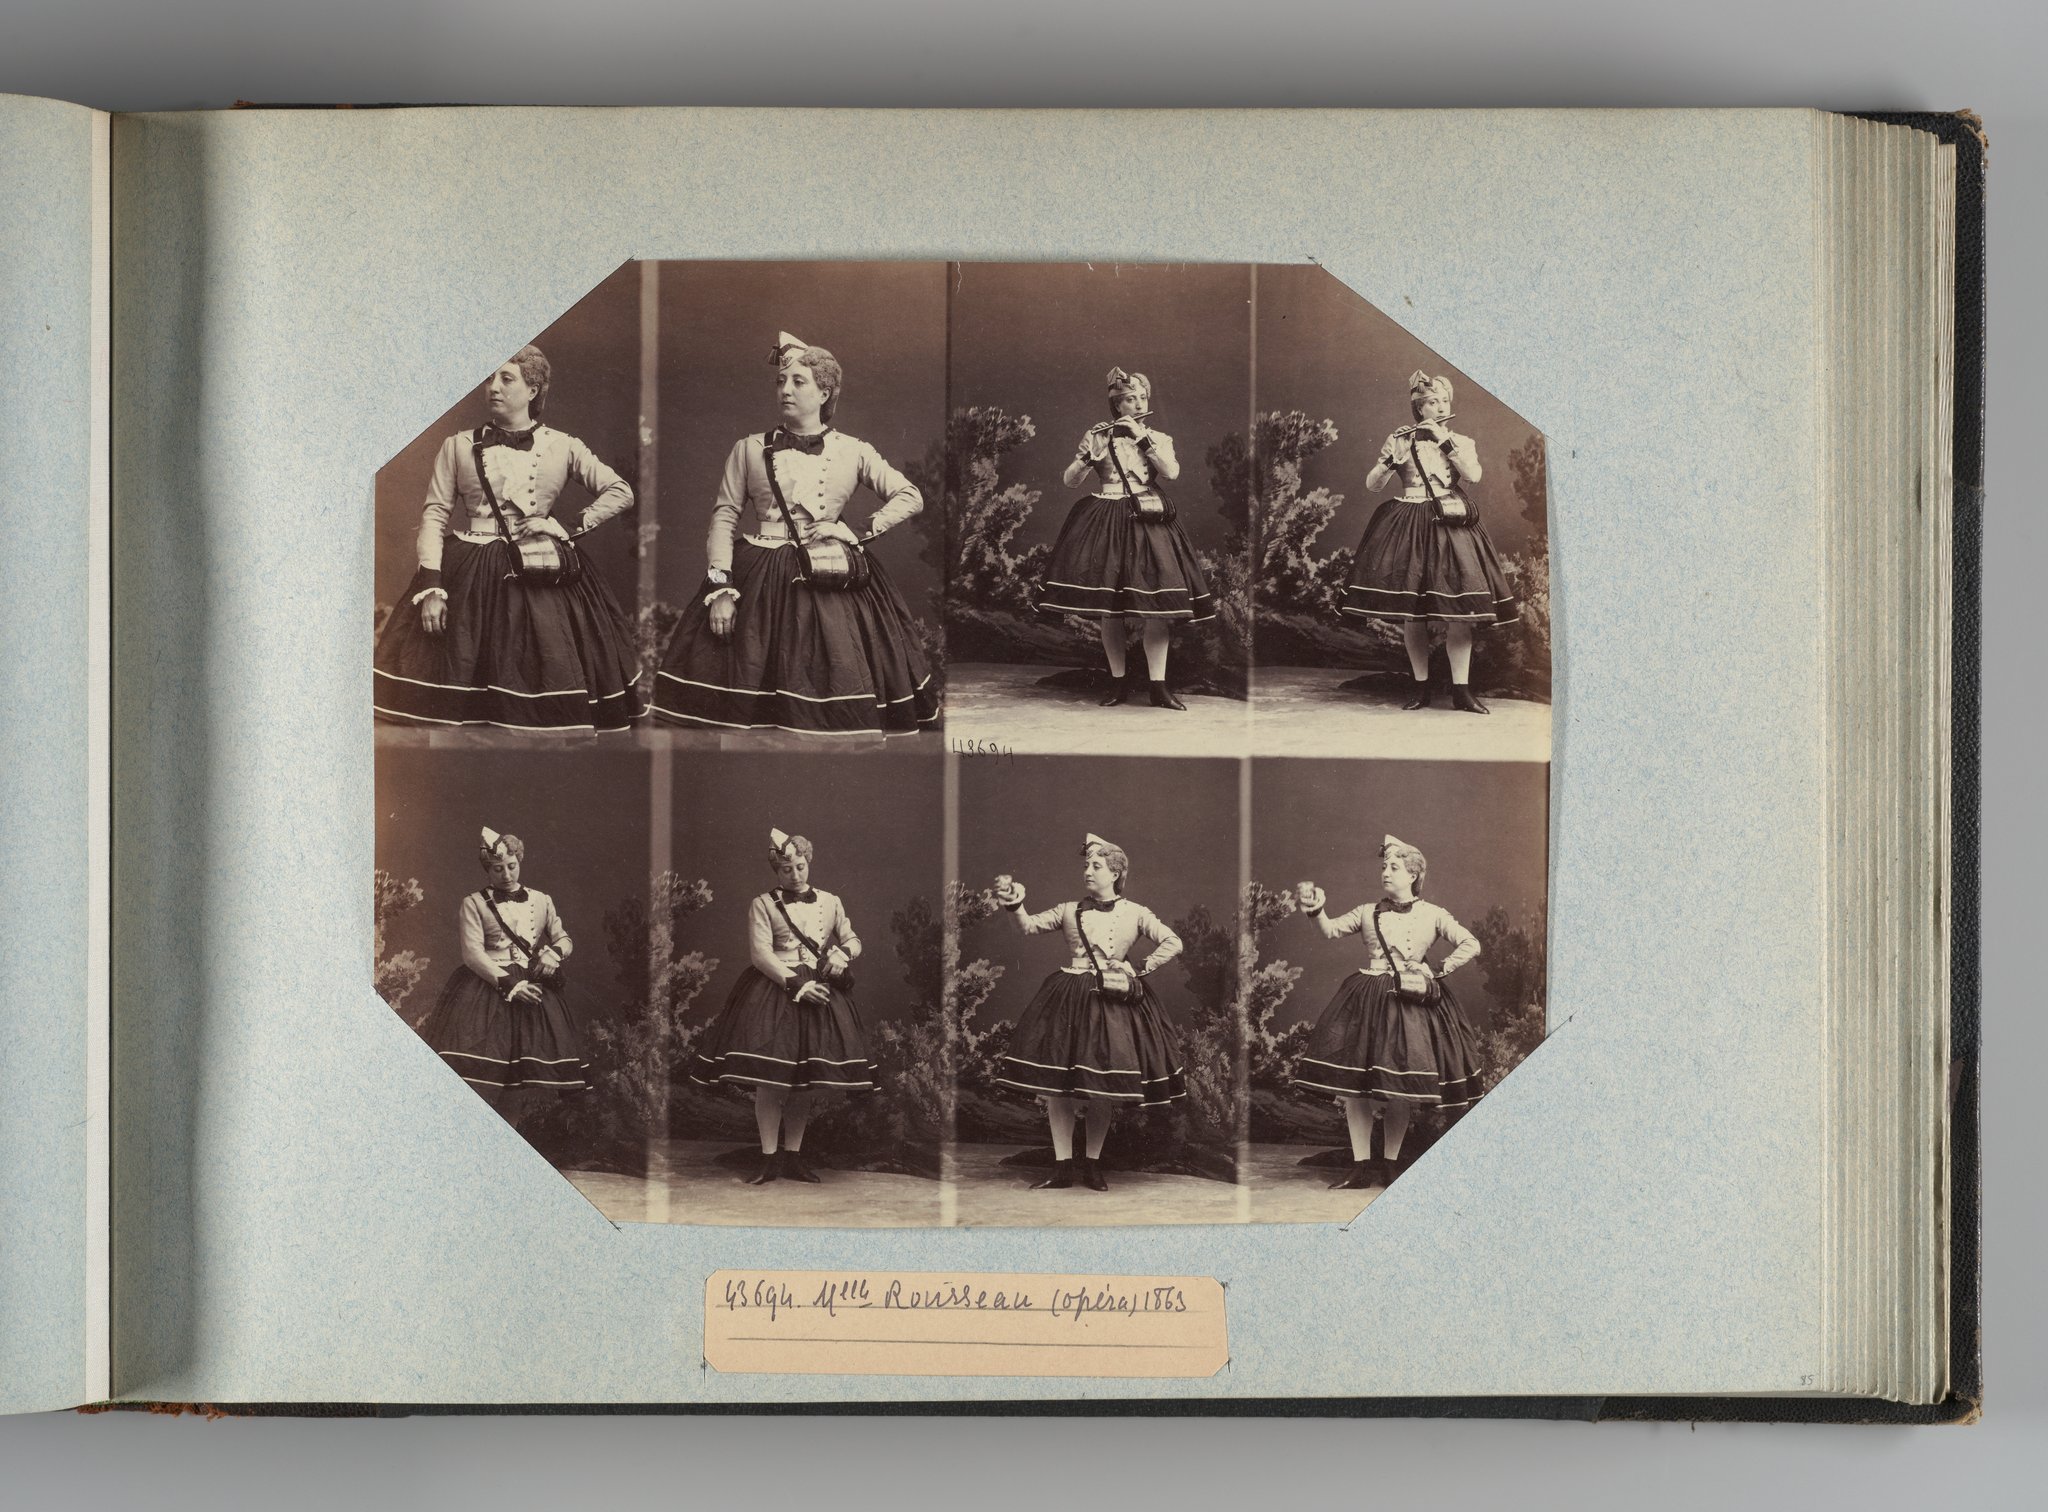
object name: photograph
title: Mlle Rousseau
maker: andré-adolphe-eugène disdéri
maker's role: artist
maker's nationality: french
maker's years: 1819-1889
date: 1863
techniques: albumen silver print, glass negative